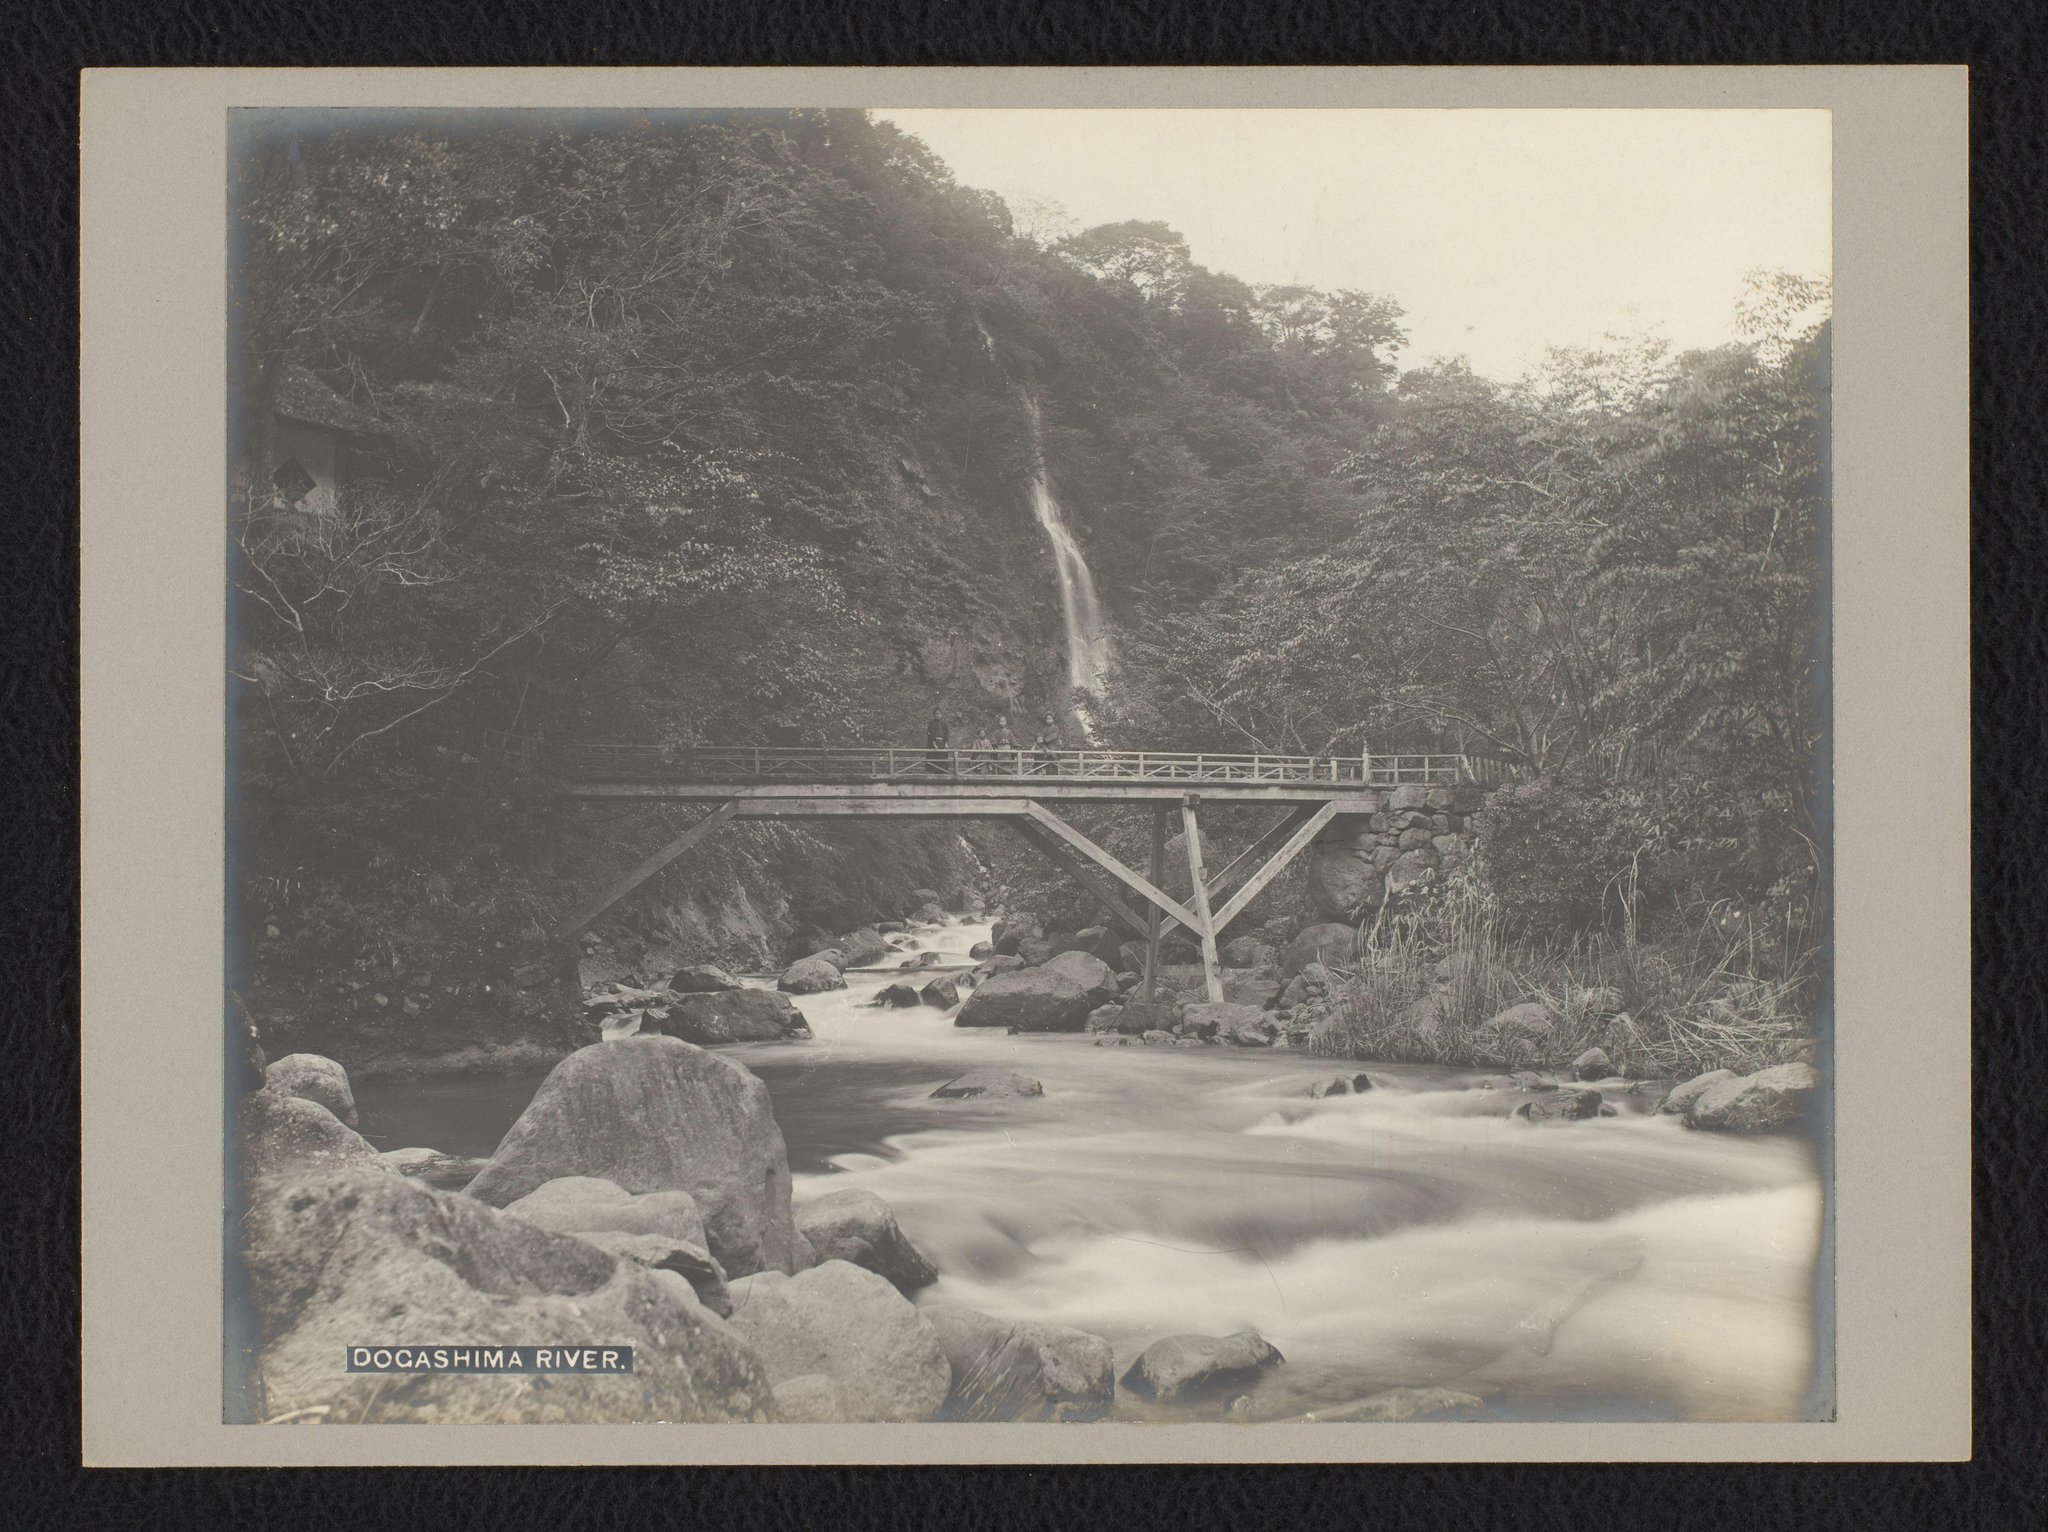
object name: photograph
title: Brug over de Dogashima rivier, Kanagawa-Ken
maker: Anonymous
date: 1895-1915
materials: cardboard, photographic support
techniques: gelatin silver print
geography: kanagawa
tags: kanagawa-ken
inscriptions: annotation: ‘18. Miyanoshita’